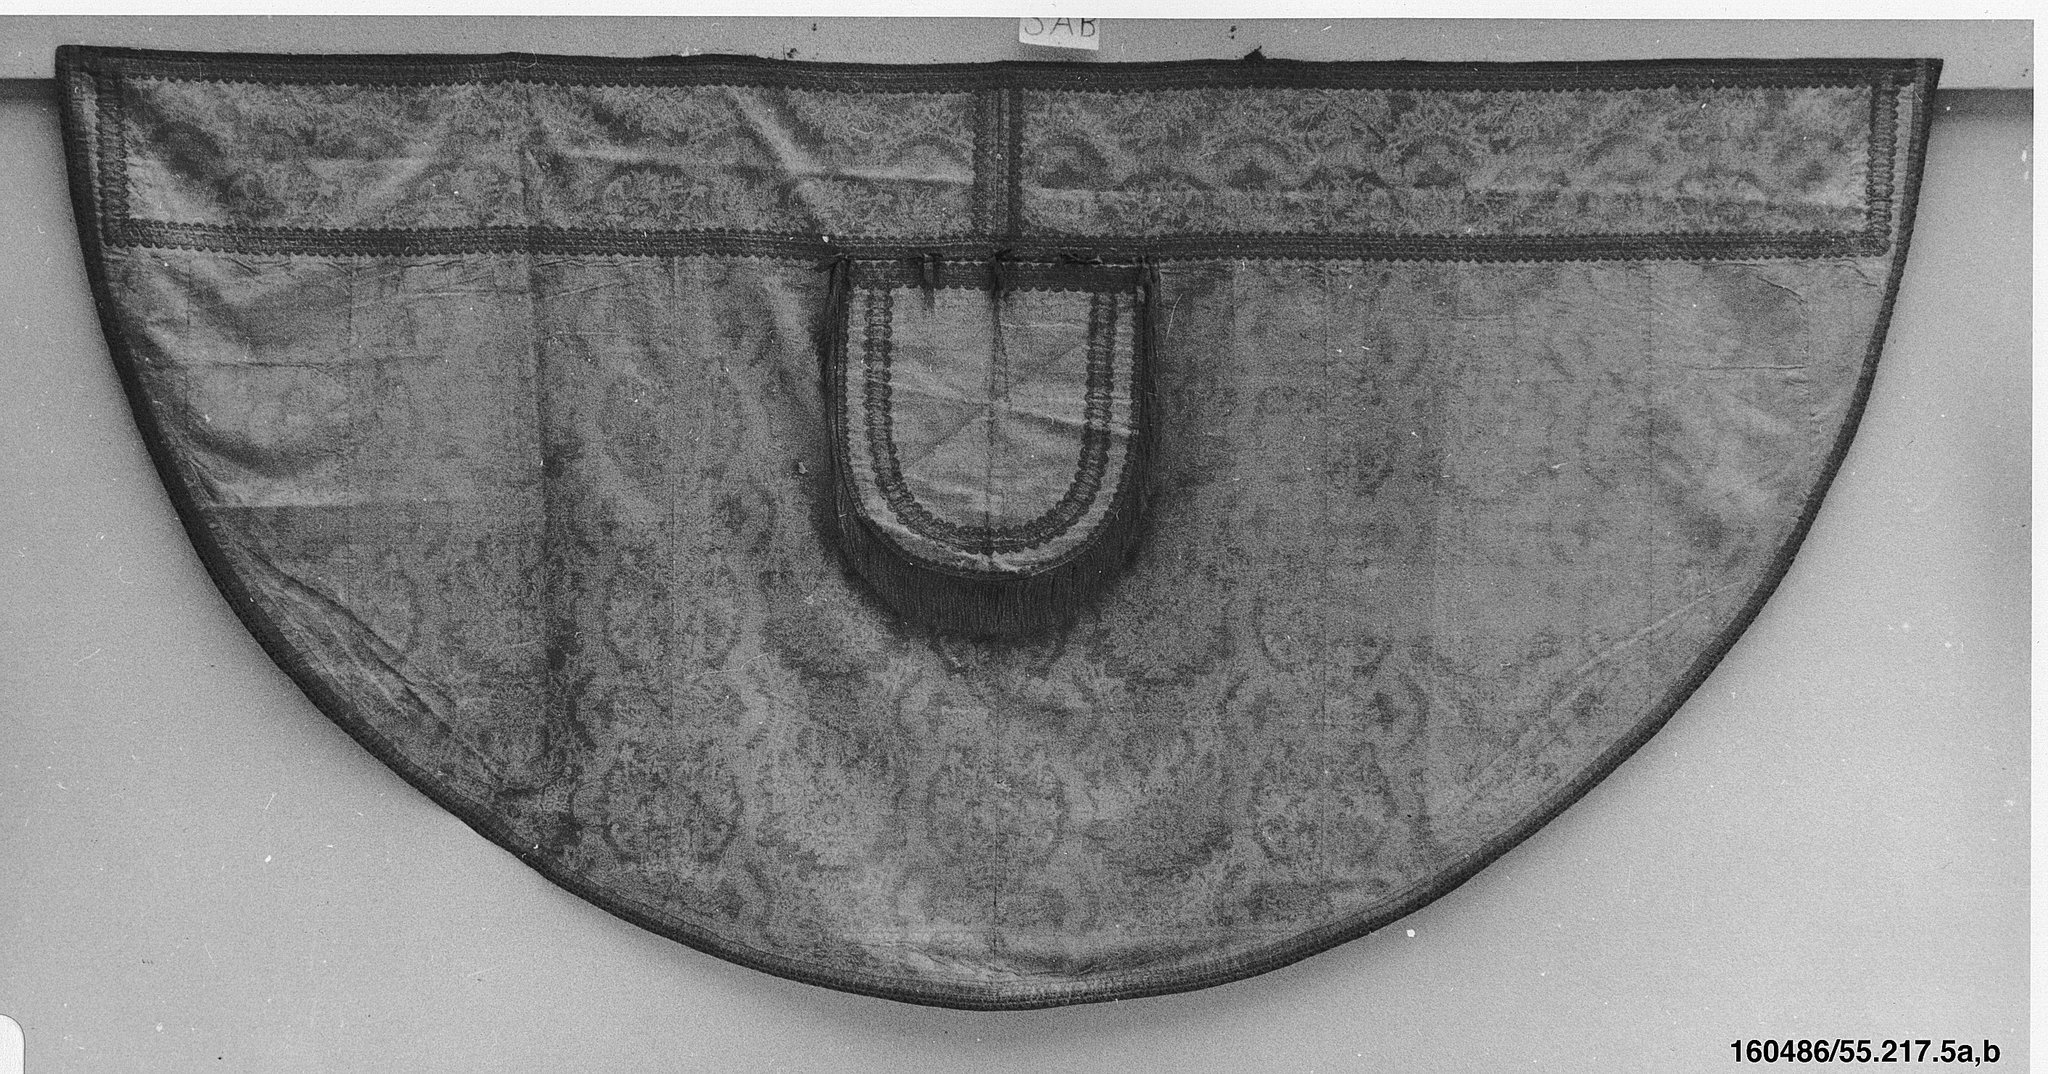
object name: cope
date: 1720-1730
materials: metal thread, silk